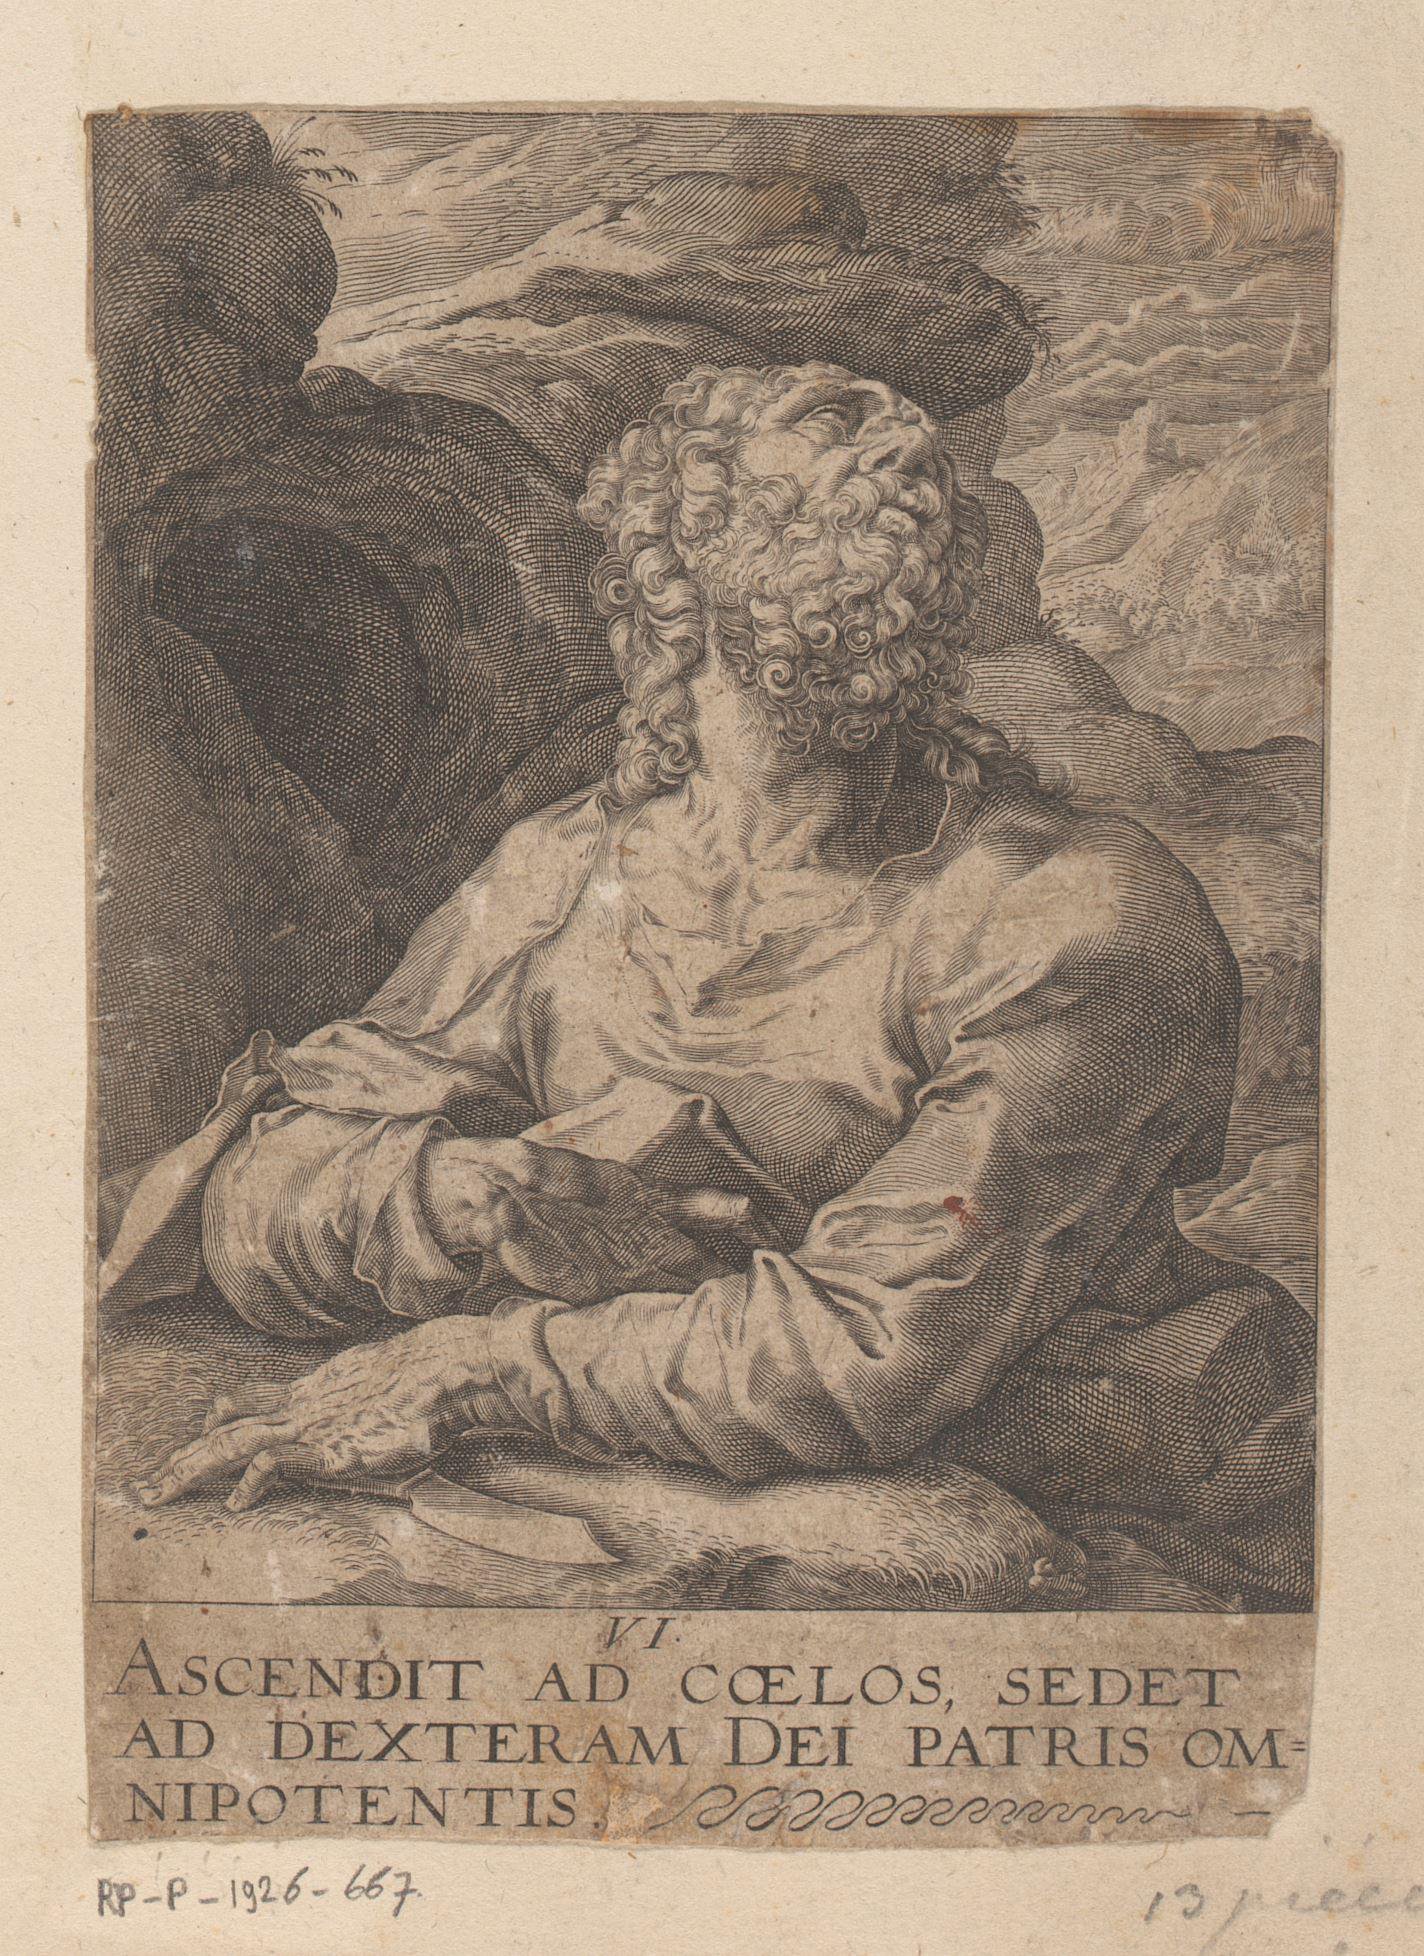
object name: print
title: Apostel Bartholomeüs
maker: jacques granthomme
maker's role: print maker, publisher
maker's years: 1550-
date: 1588-1622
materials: paper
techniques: engraving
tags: the apostle bartholomew; possible attributes: book, devil or dragon at feet, knife, scroll, flayed skin, staff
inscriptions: collector's mark: Lugt 1432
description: Maakt deel uit van een dertiendelige serie van Christus en de twaalf apostelen naar Hendrick Goltzius.